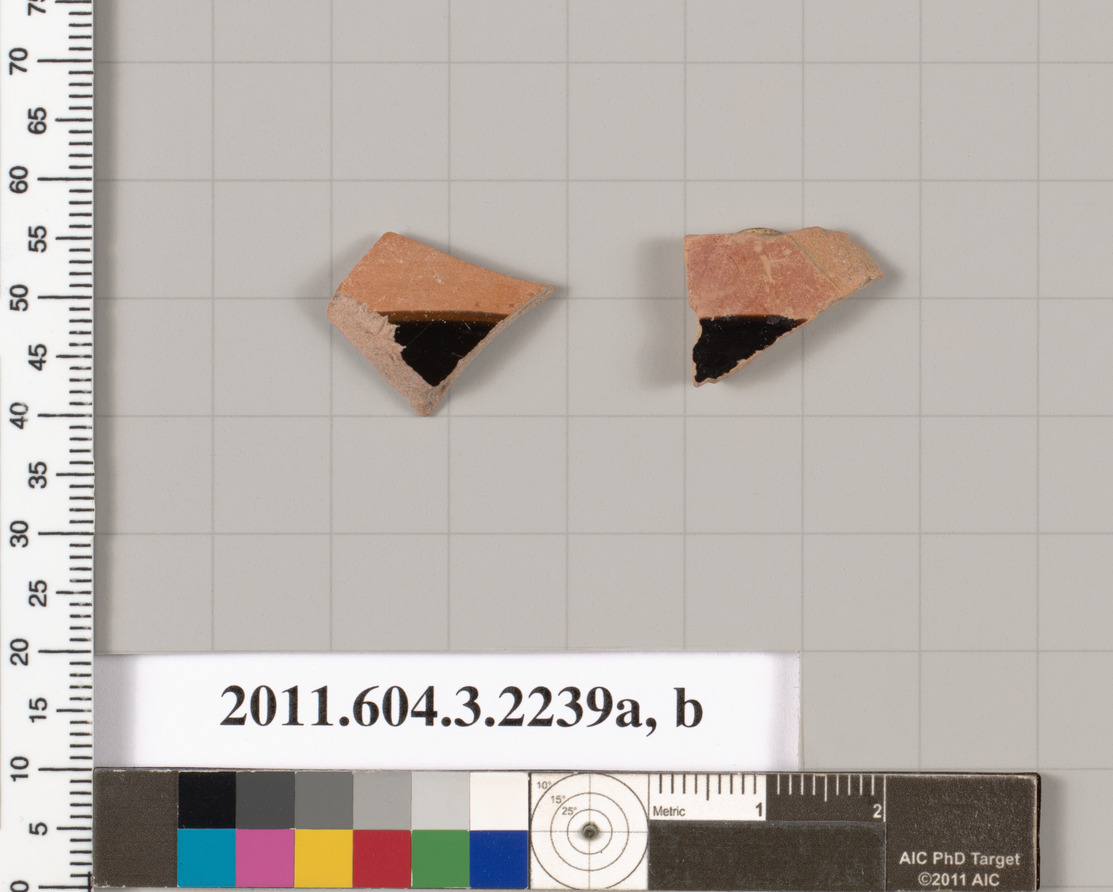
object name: kylix fragment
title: Terracotta fragments of kylikes (drinking cups)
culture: greek, attic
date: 600-401 BCE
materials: terracotta